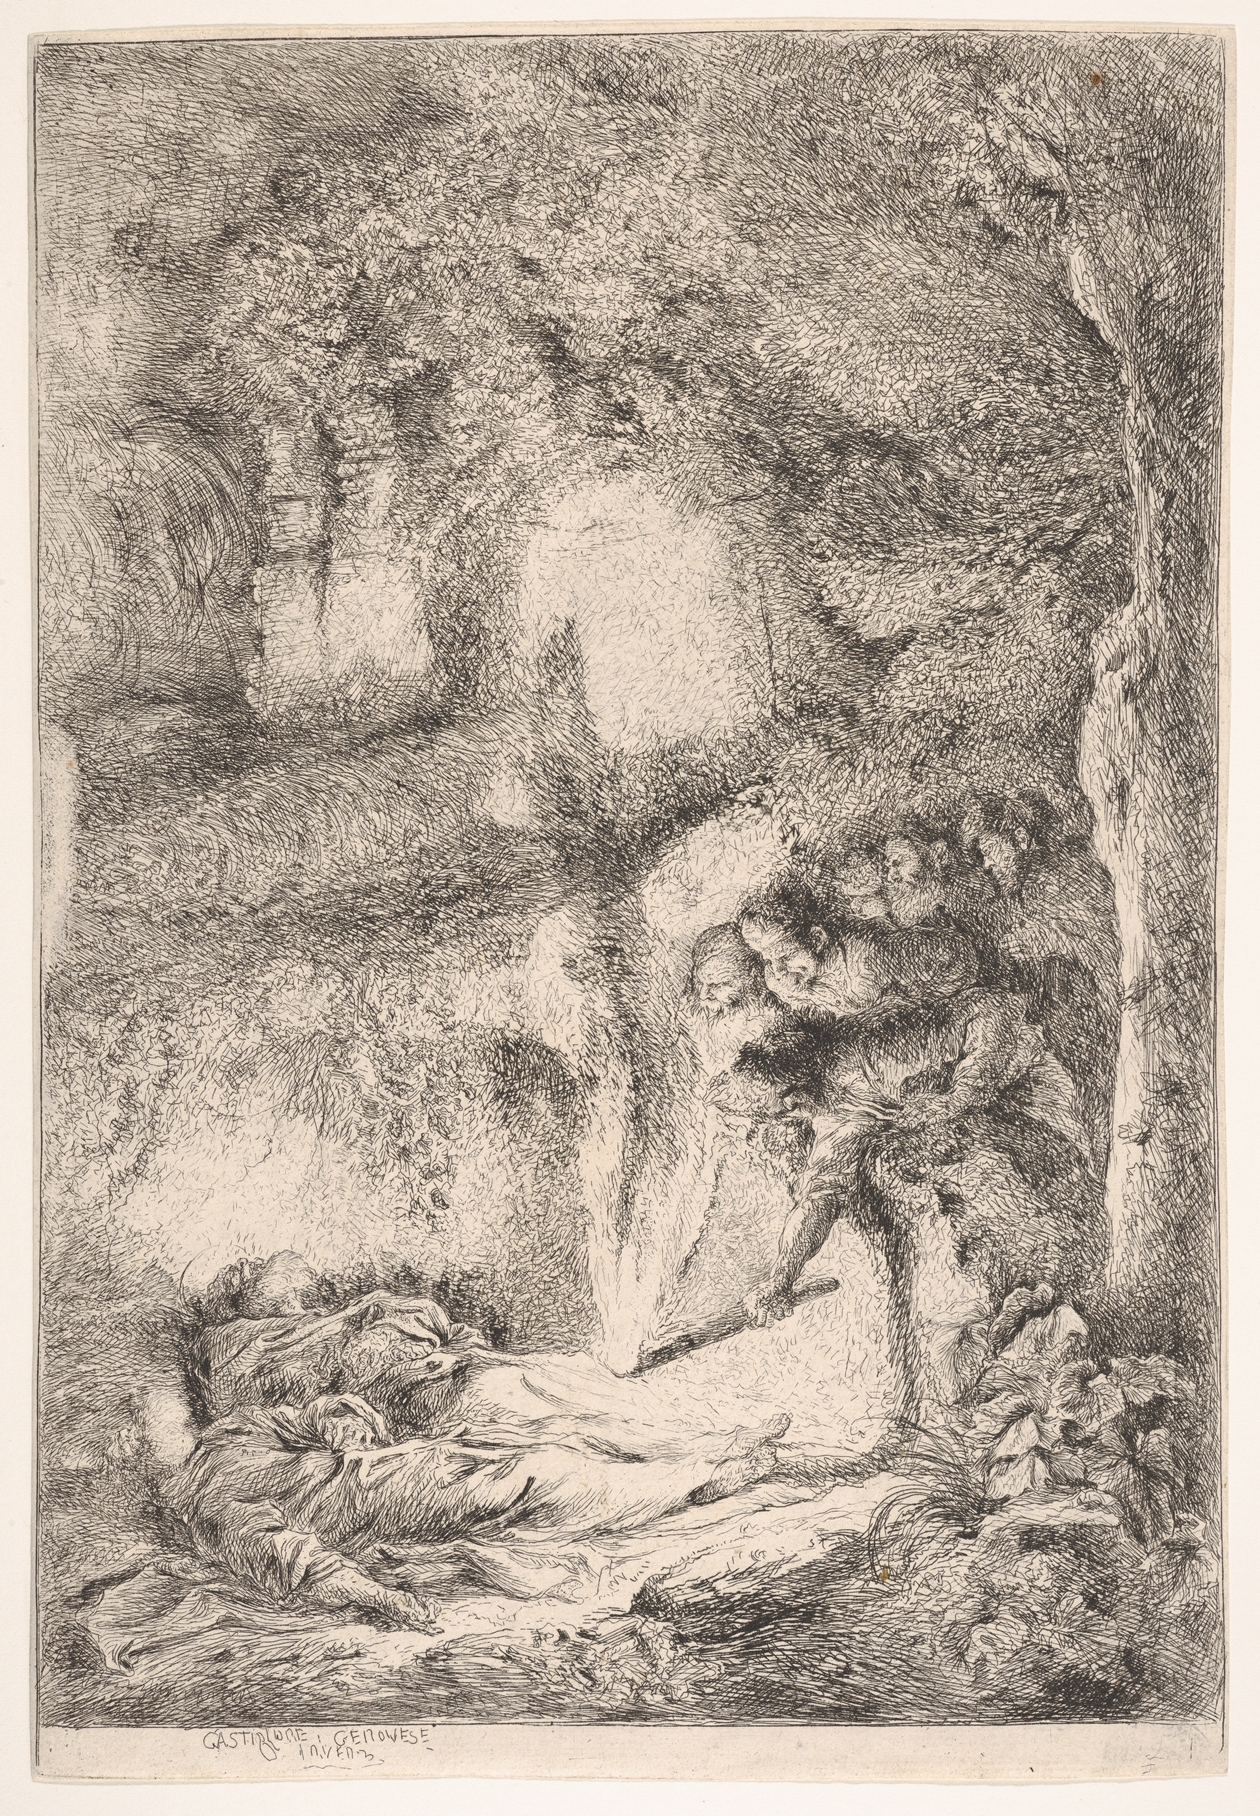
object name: print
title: Finding the bodies of Saints Peter and Paul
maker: giovanni benedetto castiglione (il grechetto)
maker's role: artist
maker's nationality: italian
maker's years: 1609-1664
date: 1647-1651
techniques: etching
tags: men,saint paul,saint peter